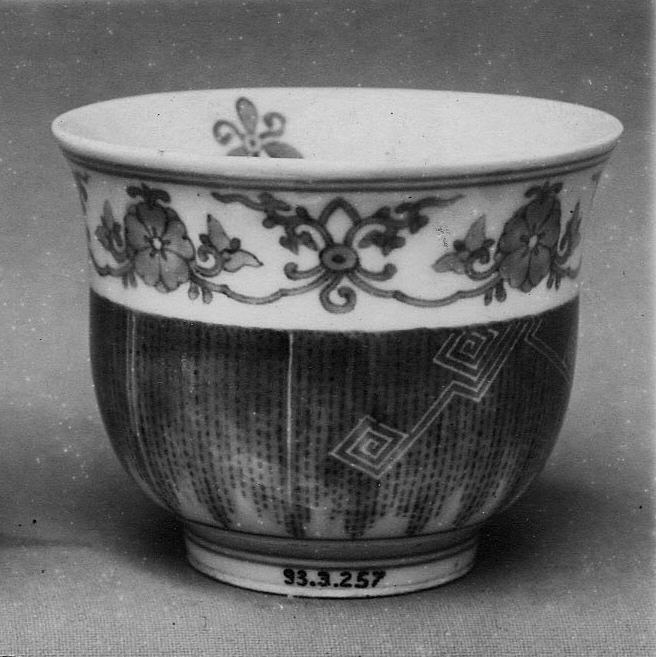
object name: cup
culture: japanese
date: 1800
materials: glaze, porcelain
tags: flowers